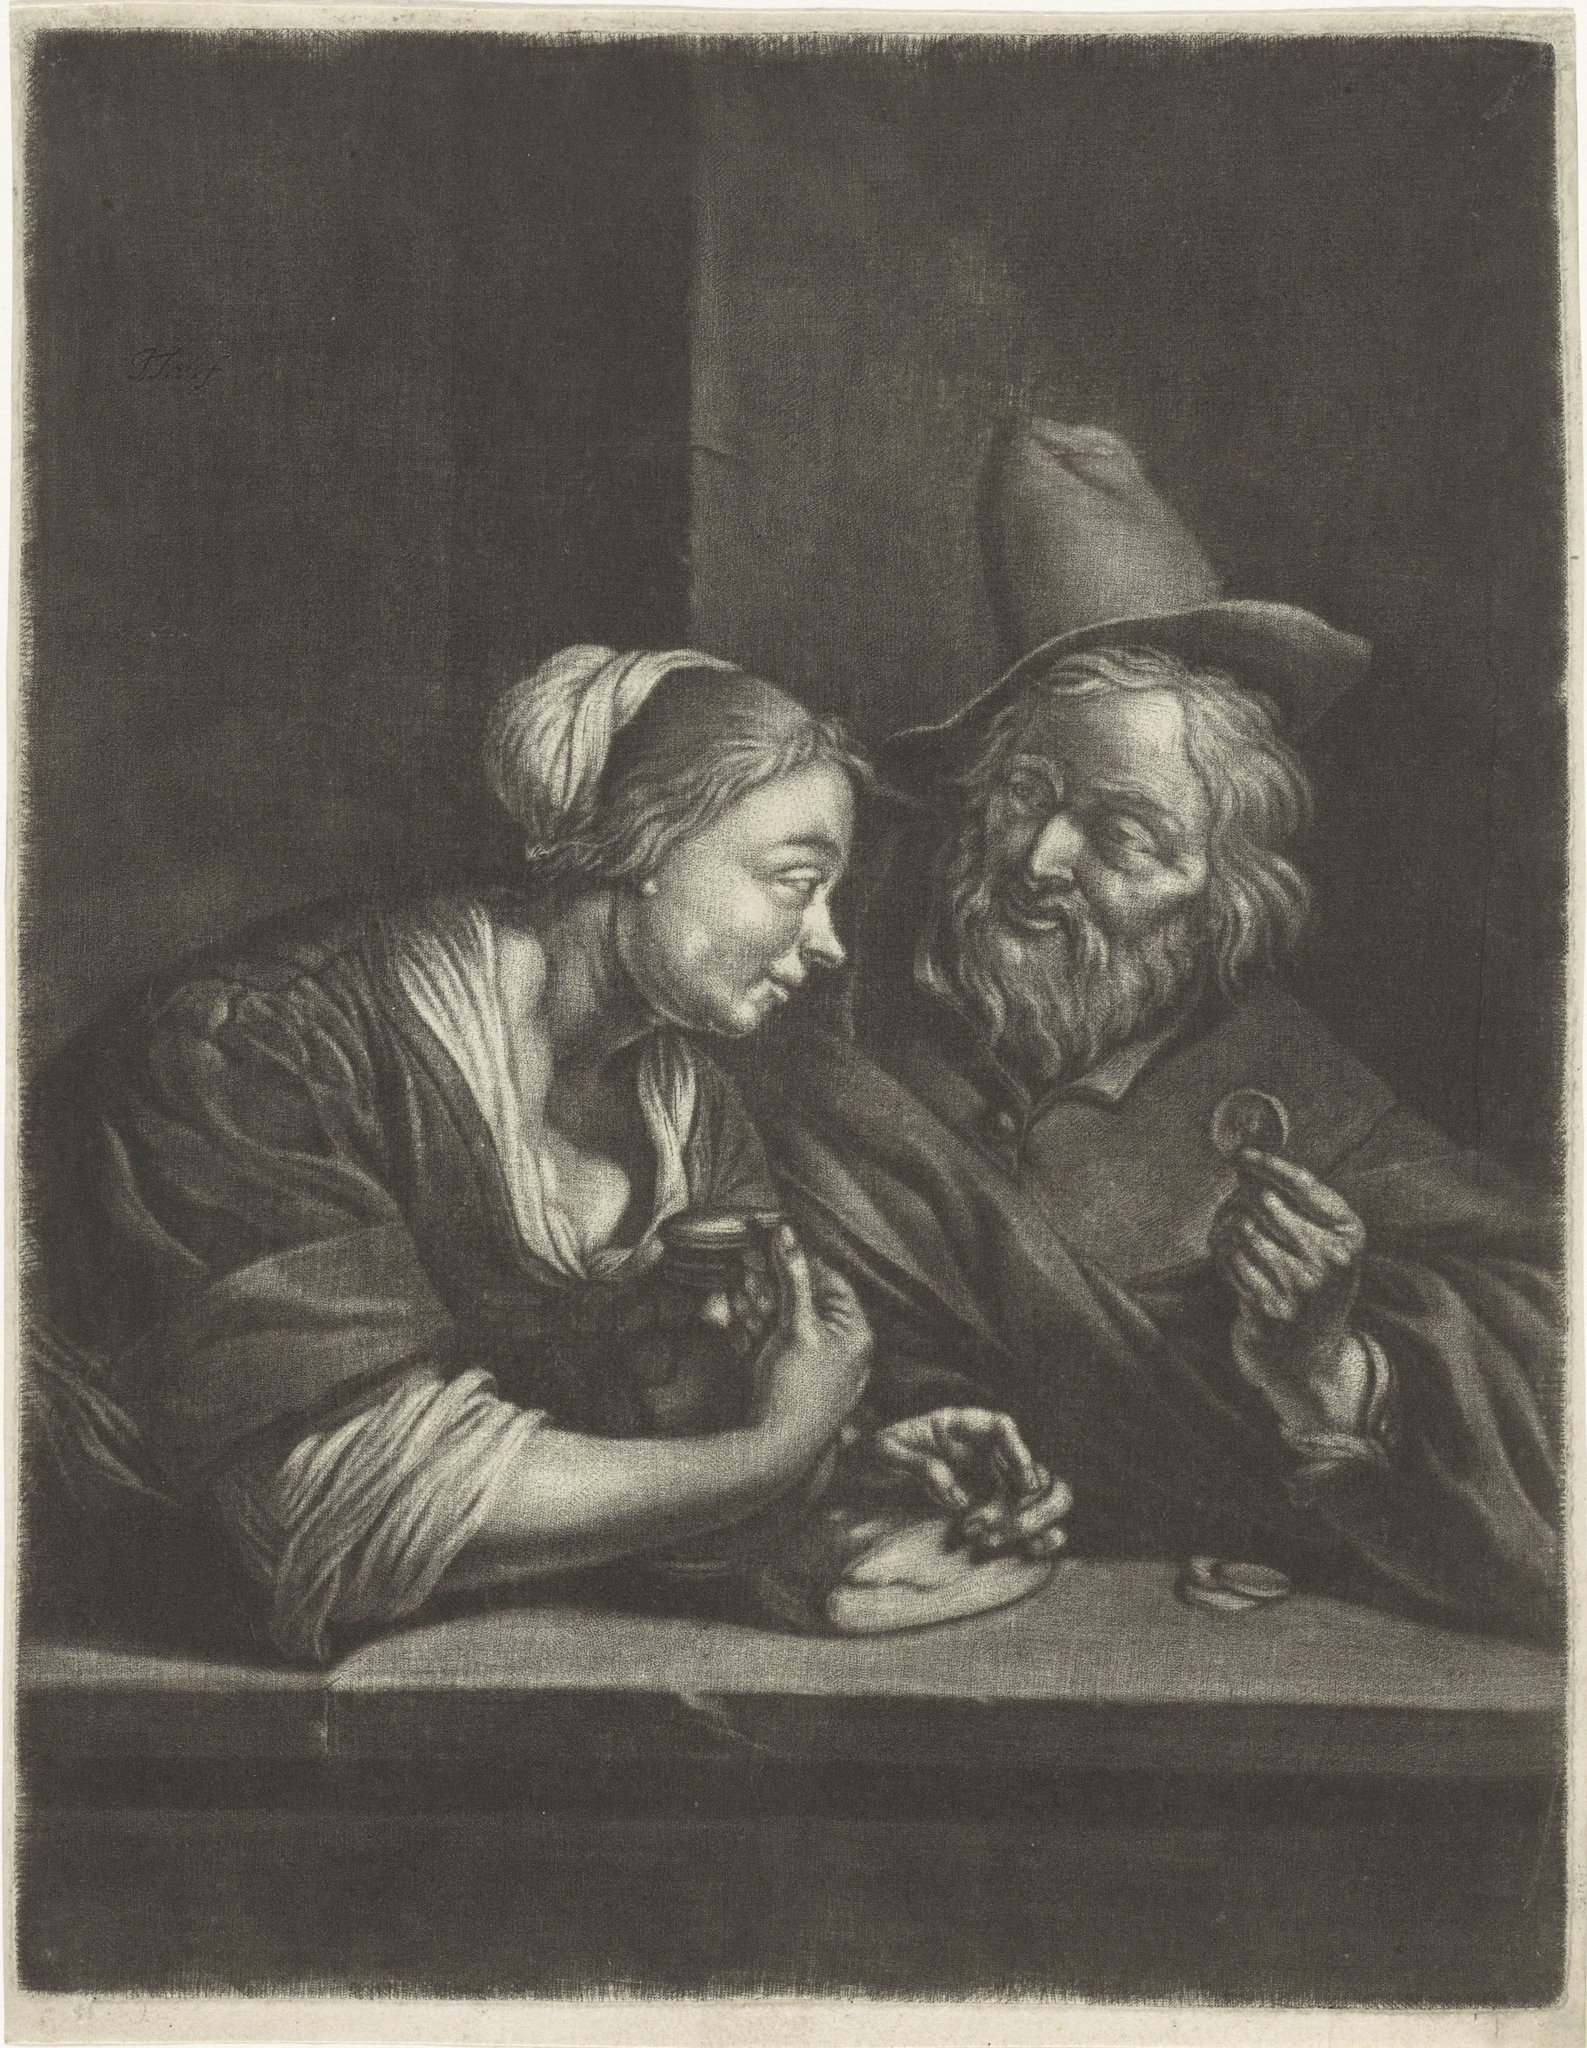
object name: print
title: Jonge vrouw en oude man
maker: jacob toorenvliet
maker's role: draughtsman, painter, print maker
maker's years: 1640-1719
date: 1651-1719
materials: paper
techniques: mezzotint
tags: whore, prostitute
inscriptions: collector's mark: Lugt 2228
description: Een man biedt een jonge vrouw geld aan. Zij kijkt naar het geldstuk dat hij in zijn hand heeft.